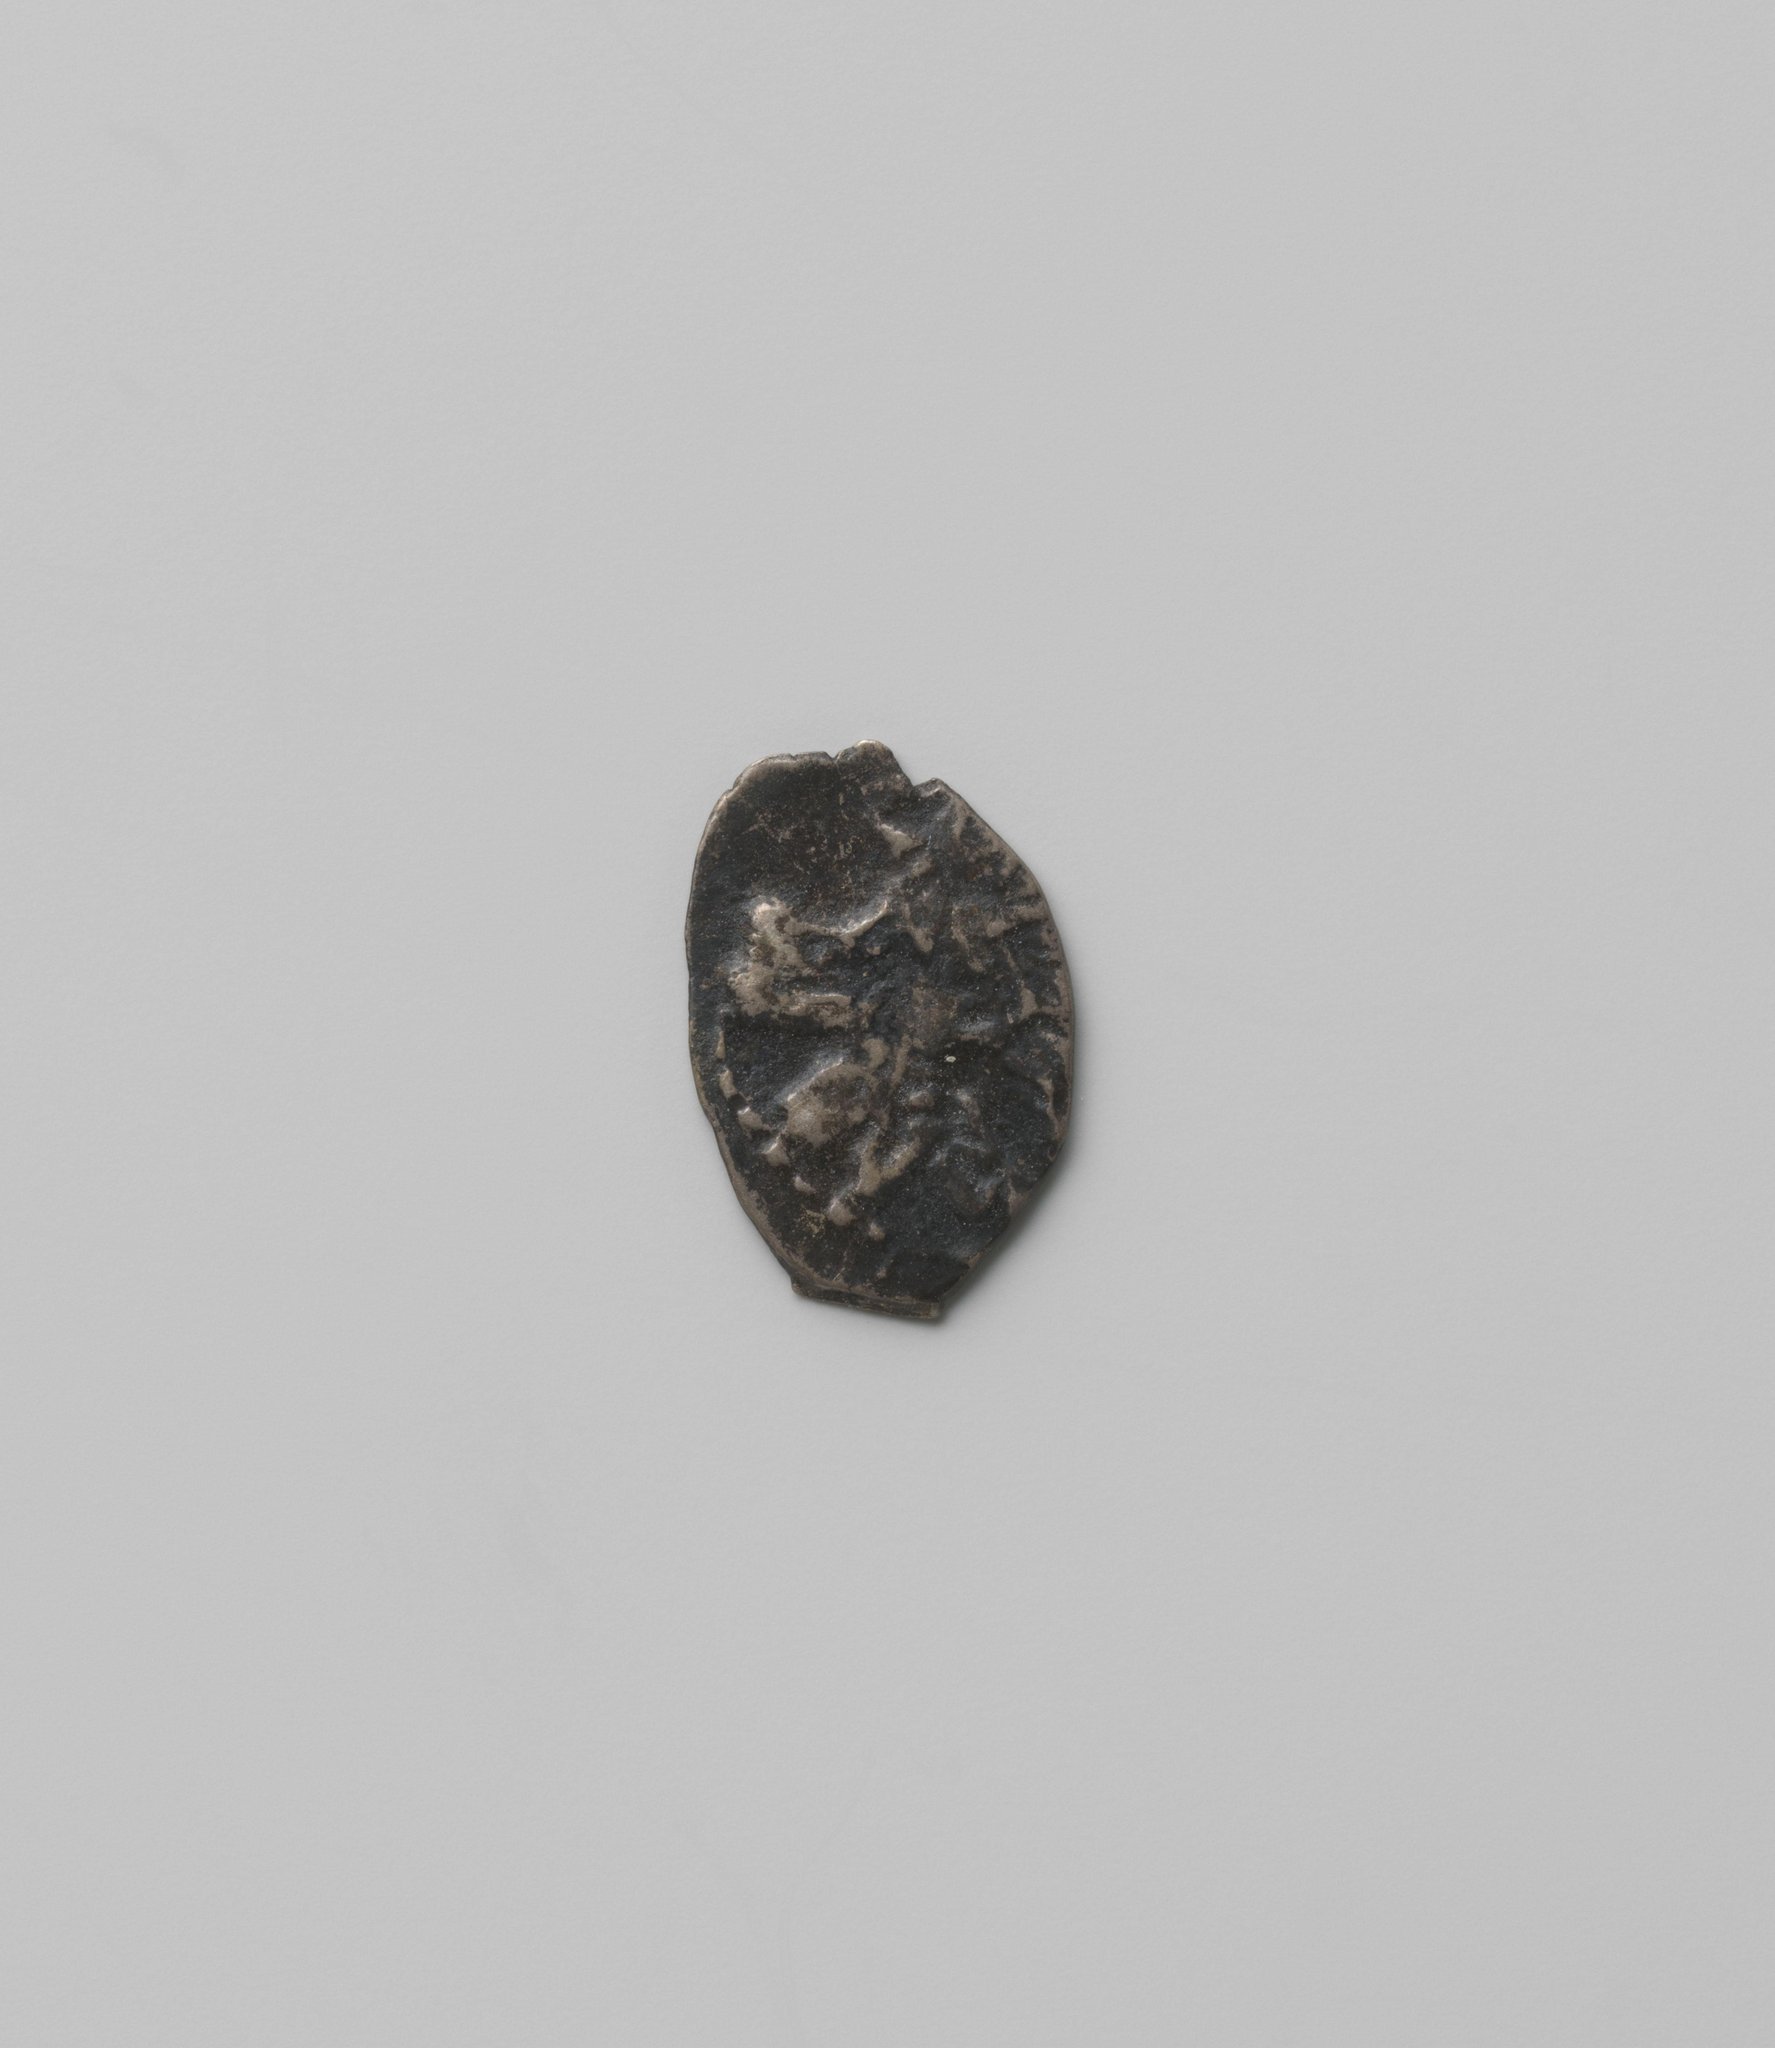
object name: miniature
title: Russische kopek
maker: Anonymous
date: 1650-1710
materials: silver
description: Zilveren muntje; Russisch kopek met onregelmatige vorm, van Alexis Michaelowitz, czaar van Rusland (1645 - 1676).